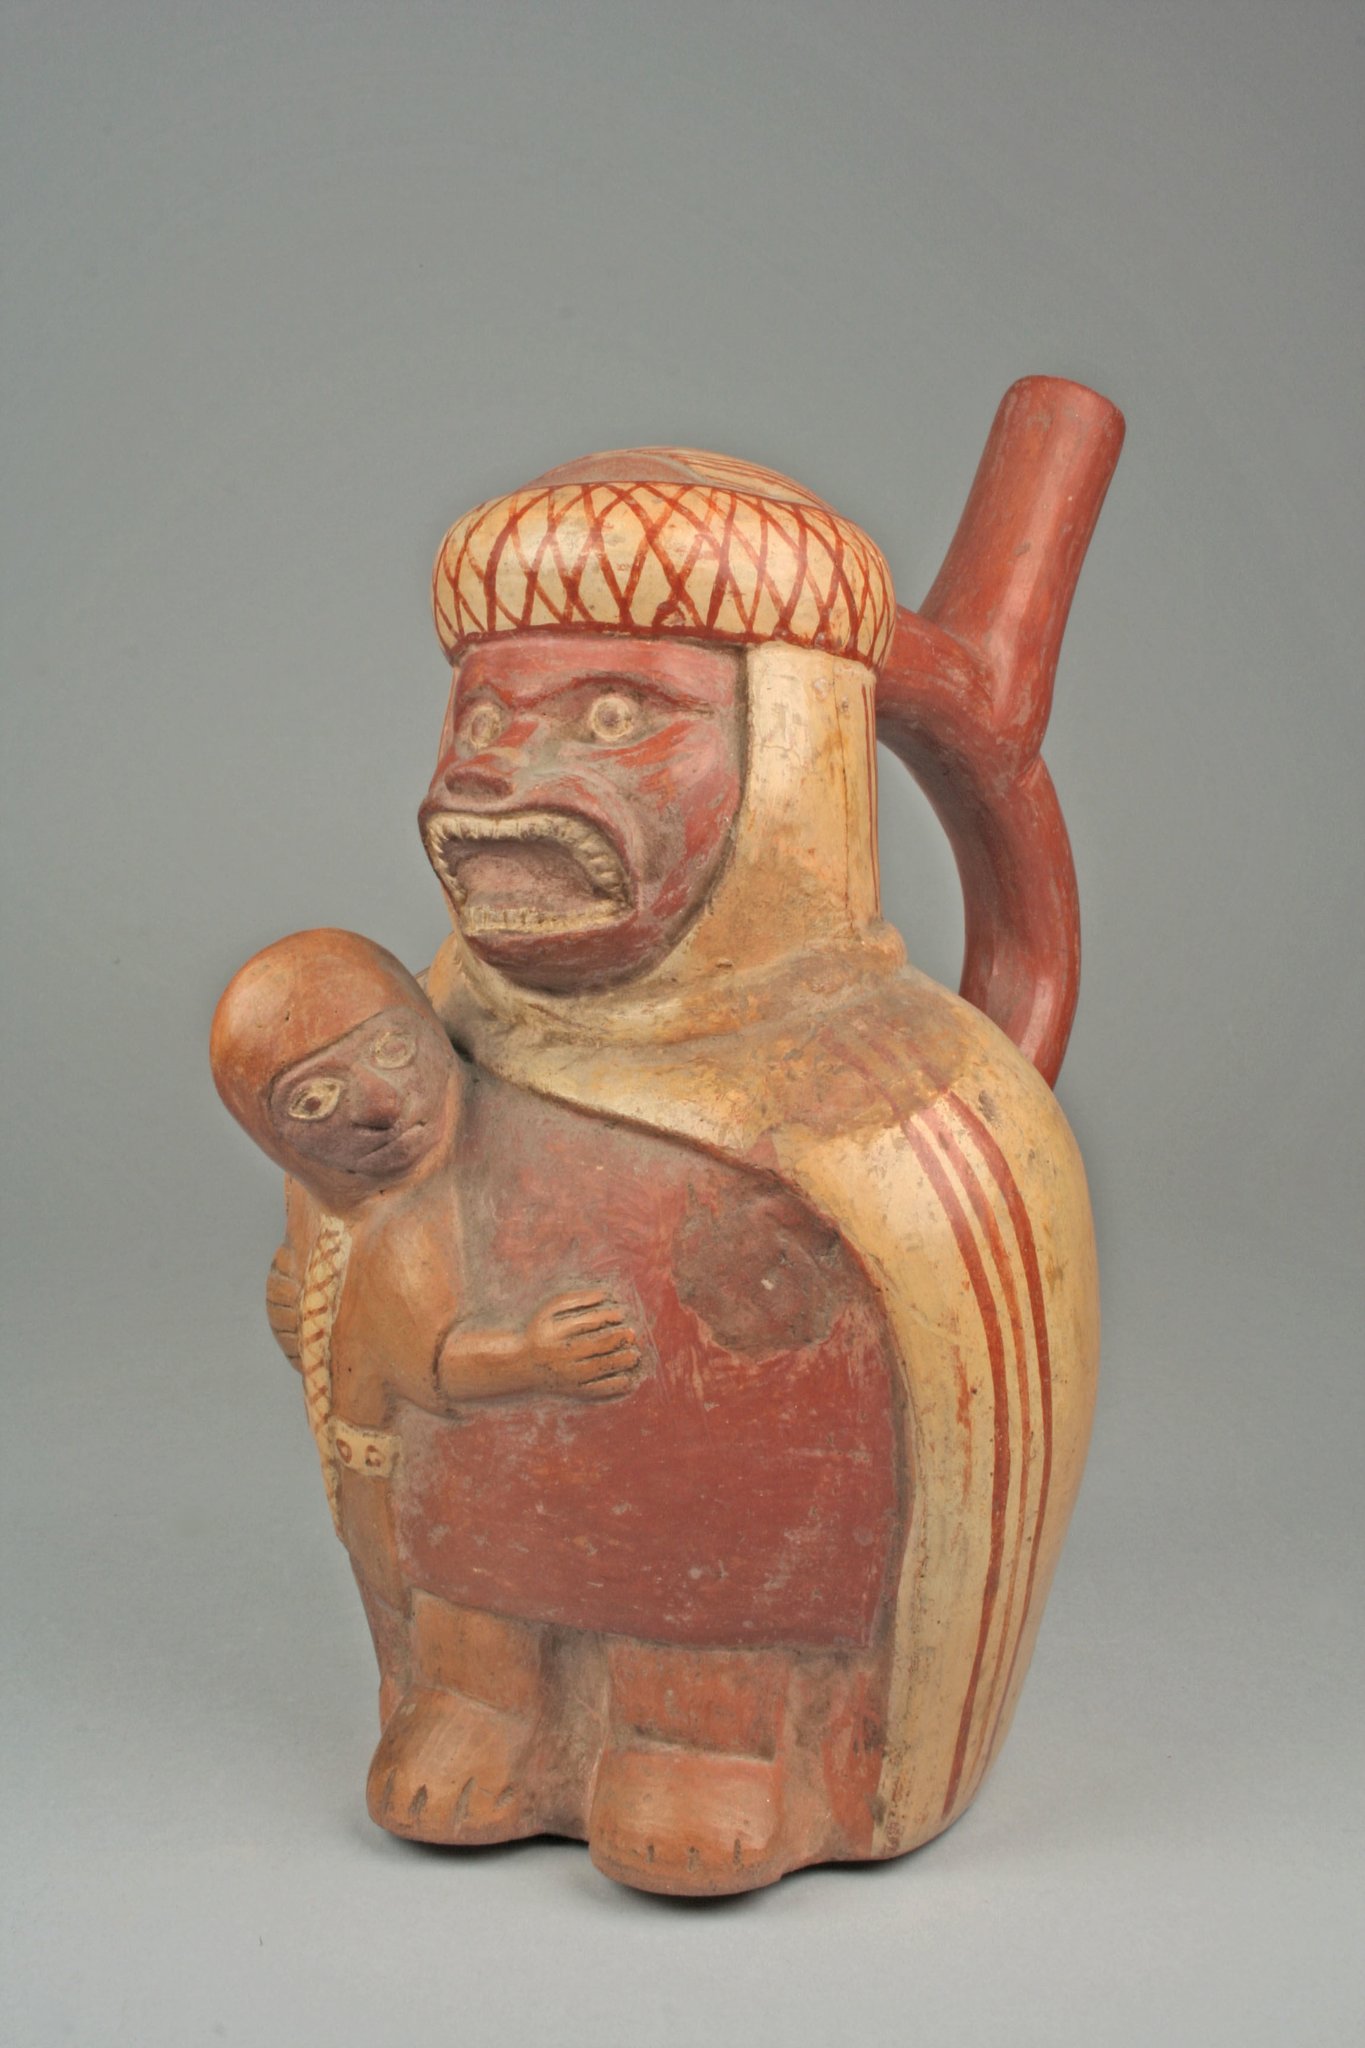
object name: bottle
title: Stirrup Spout Bottle with Figures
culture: moche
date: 201-700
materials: ceramic, pigment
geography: peru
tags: human figures